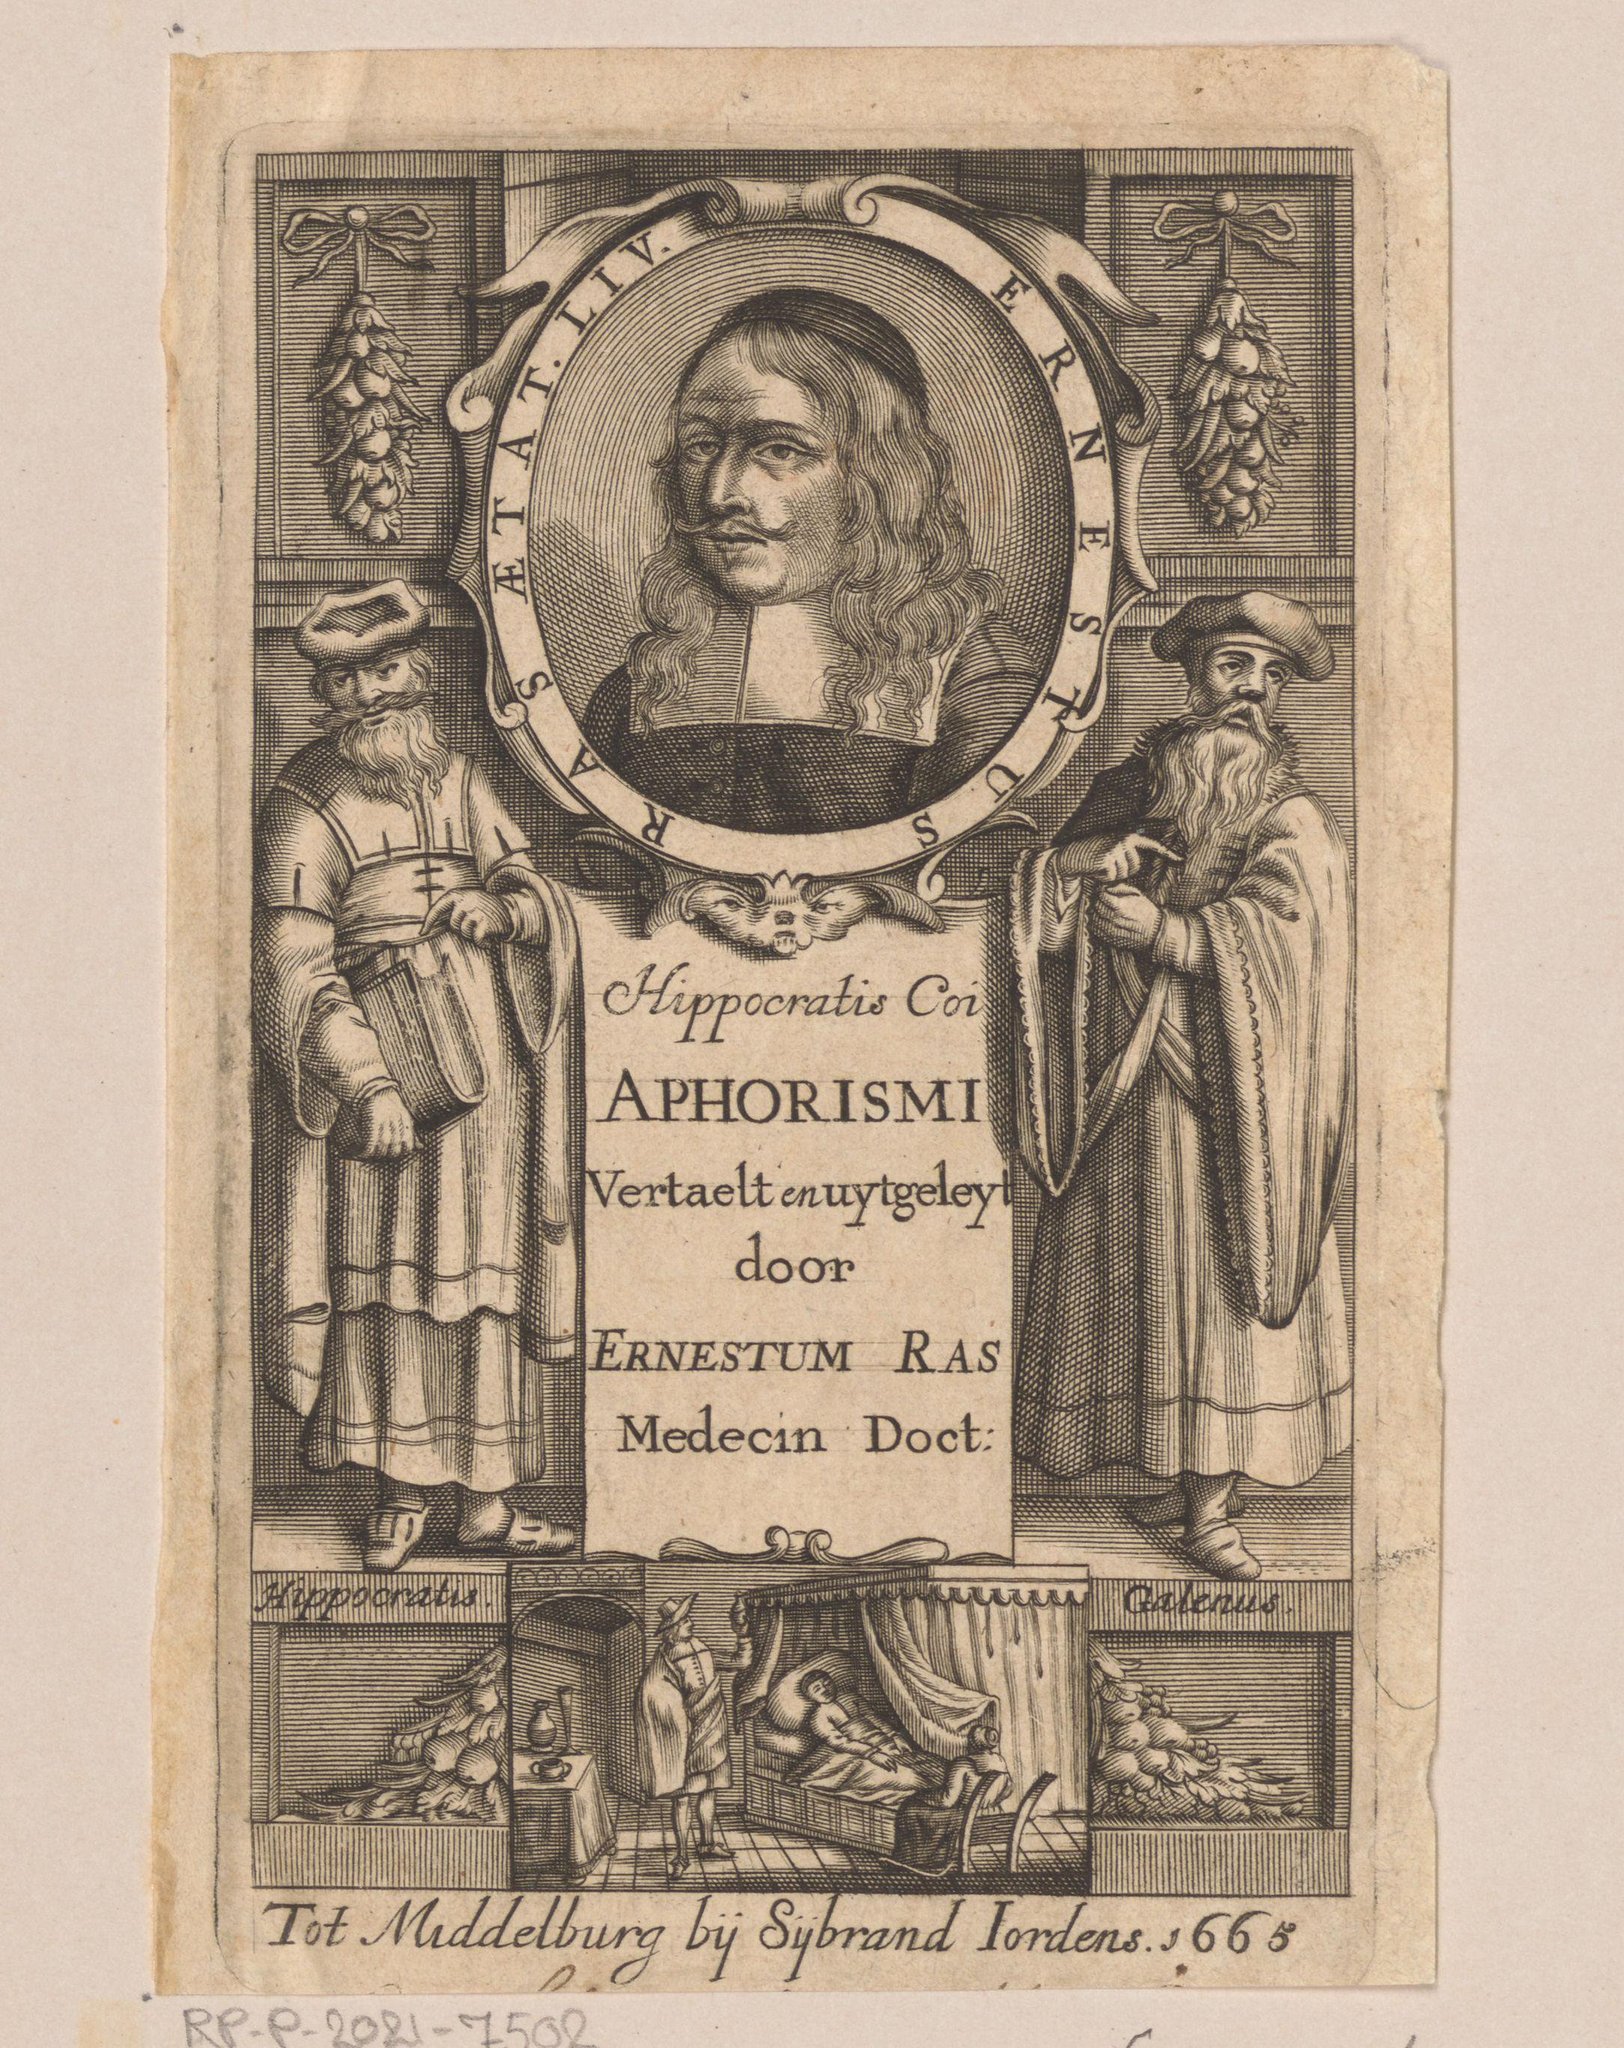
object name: print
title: Portret van Ernst Ras op 54-jarige leeftijd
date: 1665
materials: paper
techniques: engraving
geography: middelburg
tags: sick-bed, historical persons, physician, doctor, patient, sick person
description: Naast het portret Hippocrates van Kos en Claudius Galenus. Onder het portret een dokter aan een bed met daarin een zieke.